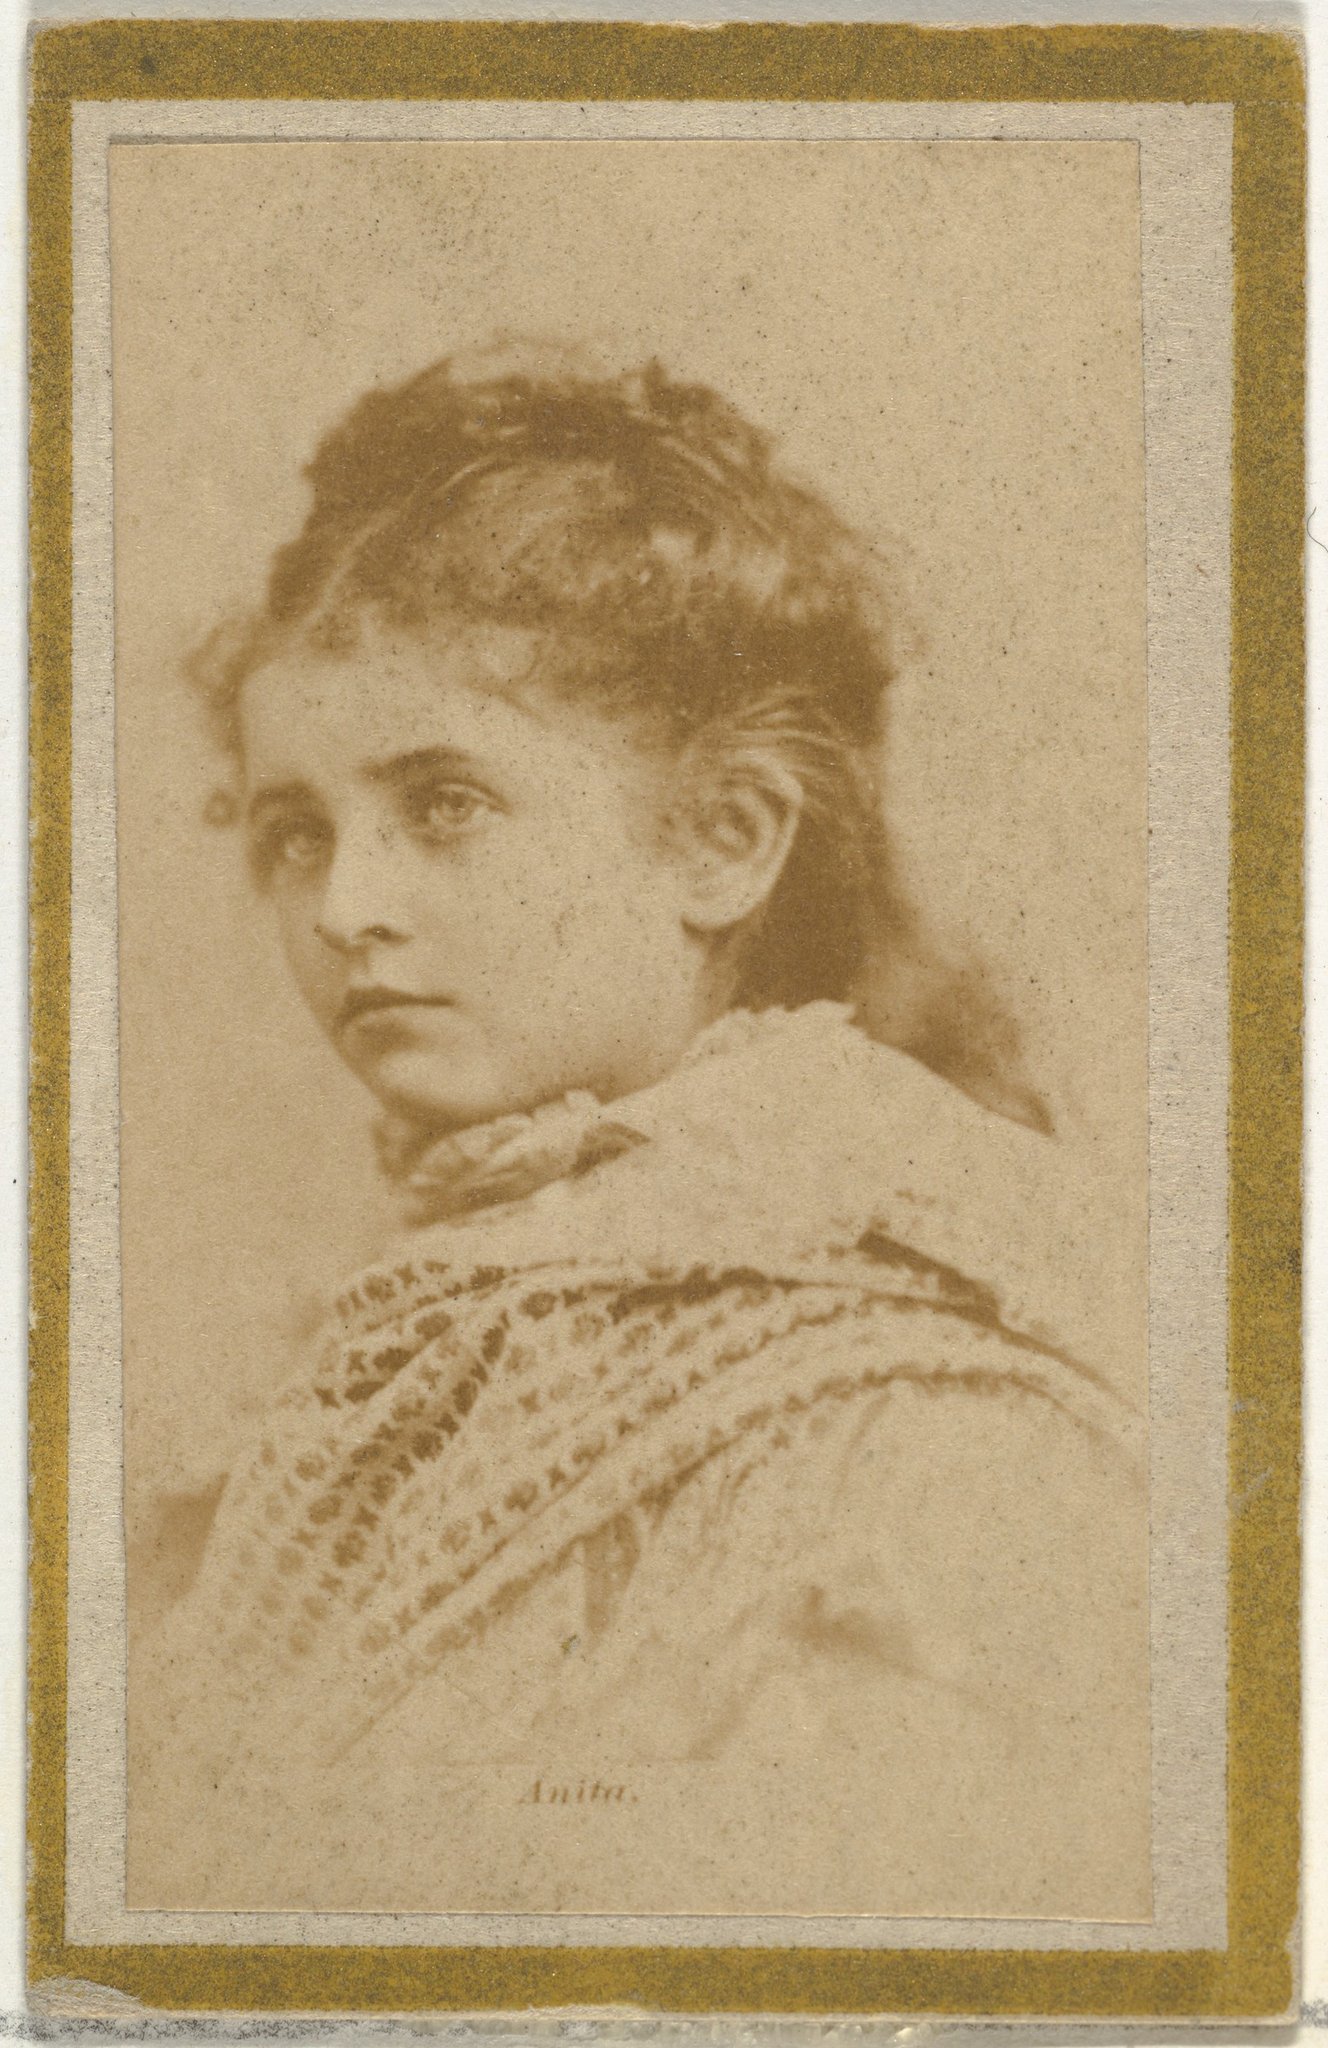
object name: photograph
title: Anita, from the Actresses and Celebrities series (N60, Type 2) promoting Little Beauties Cigarettes for Allen & Ginter brand tobacco products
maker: allen & ginter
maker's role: publisher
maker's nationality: american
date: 1887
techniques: albumen silver print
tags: girls,portraits,actresses